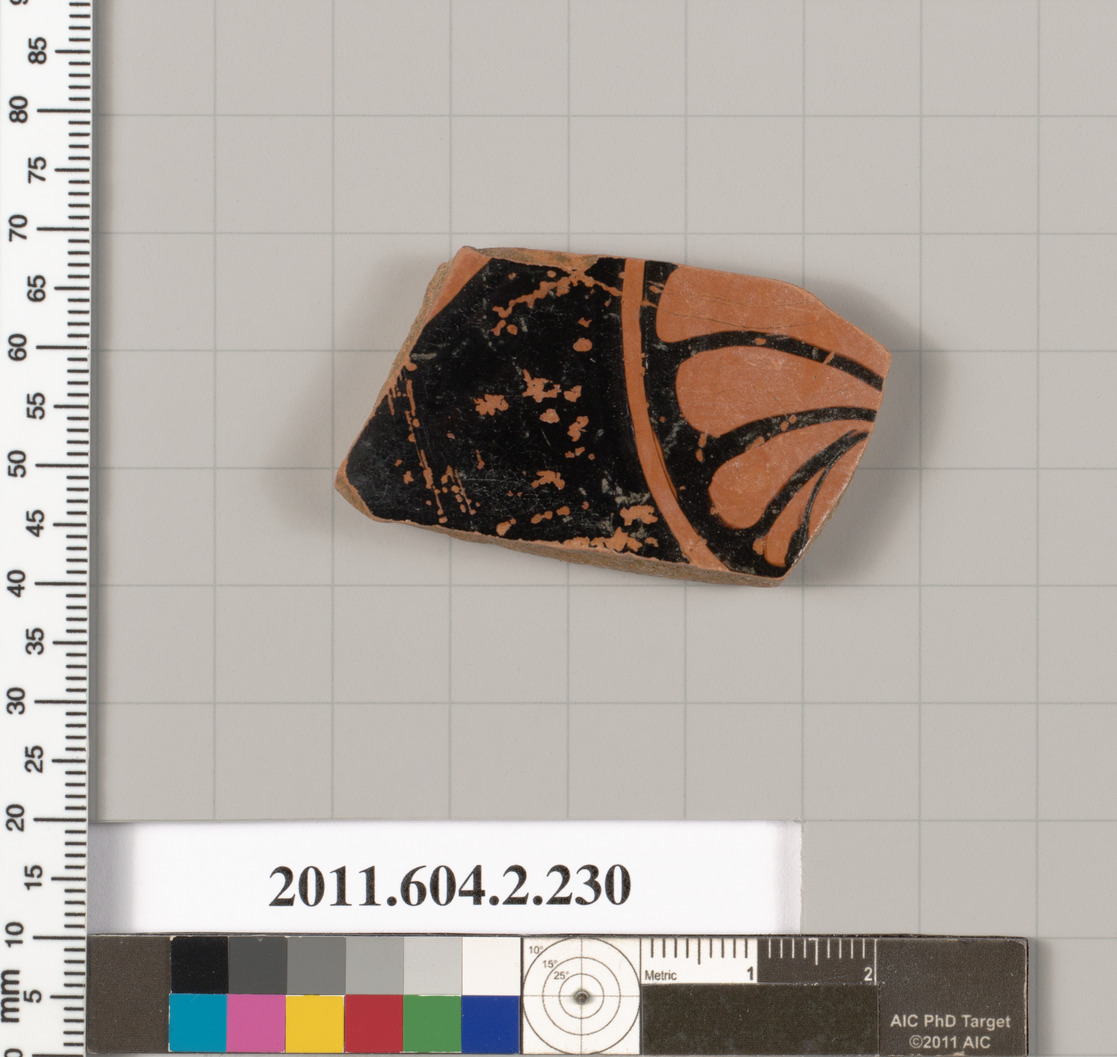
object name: stamnos fragment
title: Terracotta fragment of a stamnos (jar)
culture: greek, attic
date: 470-450 BCE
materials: terracotta